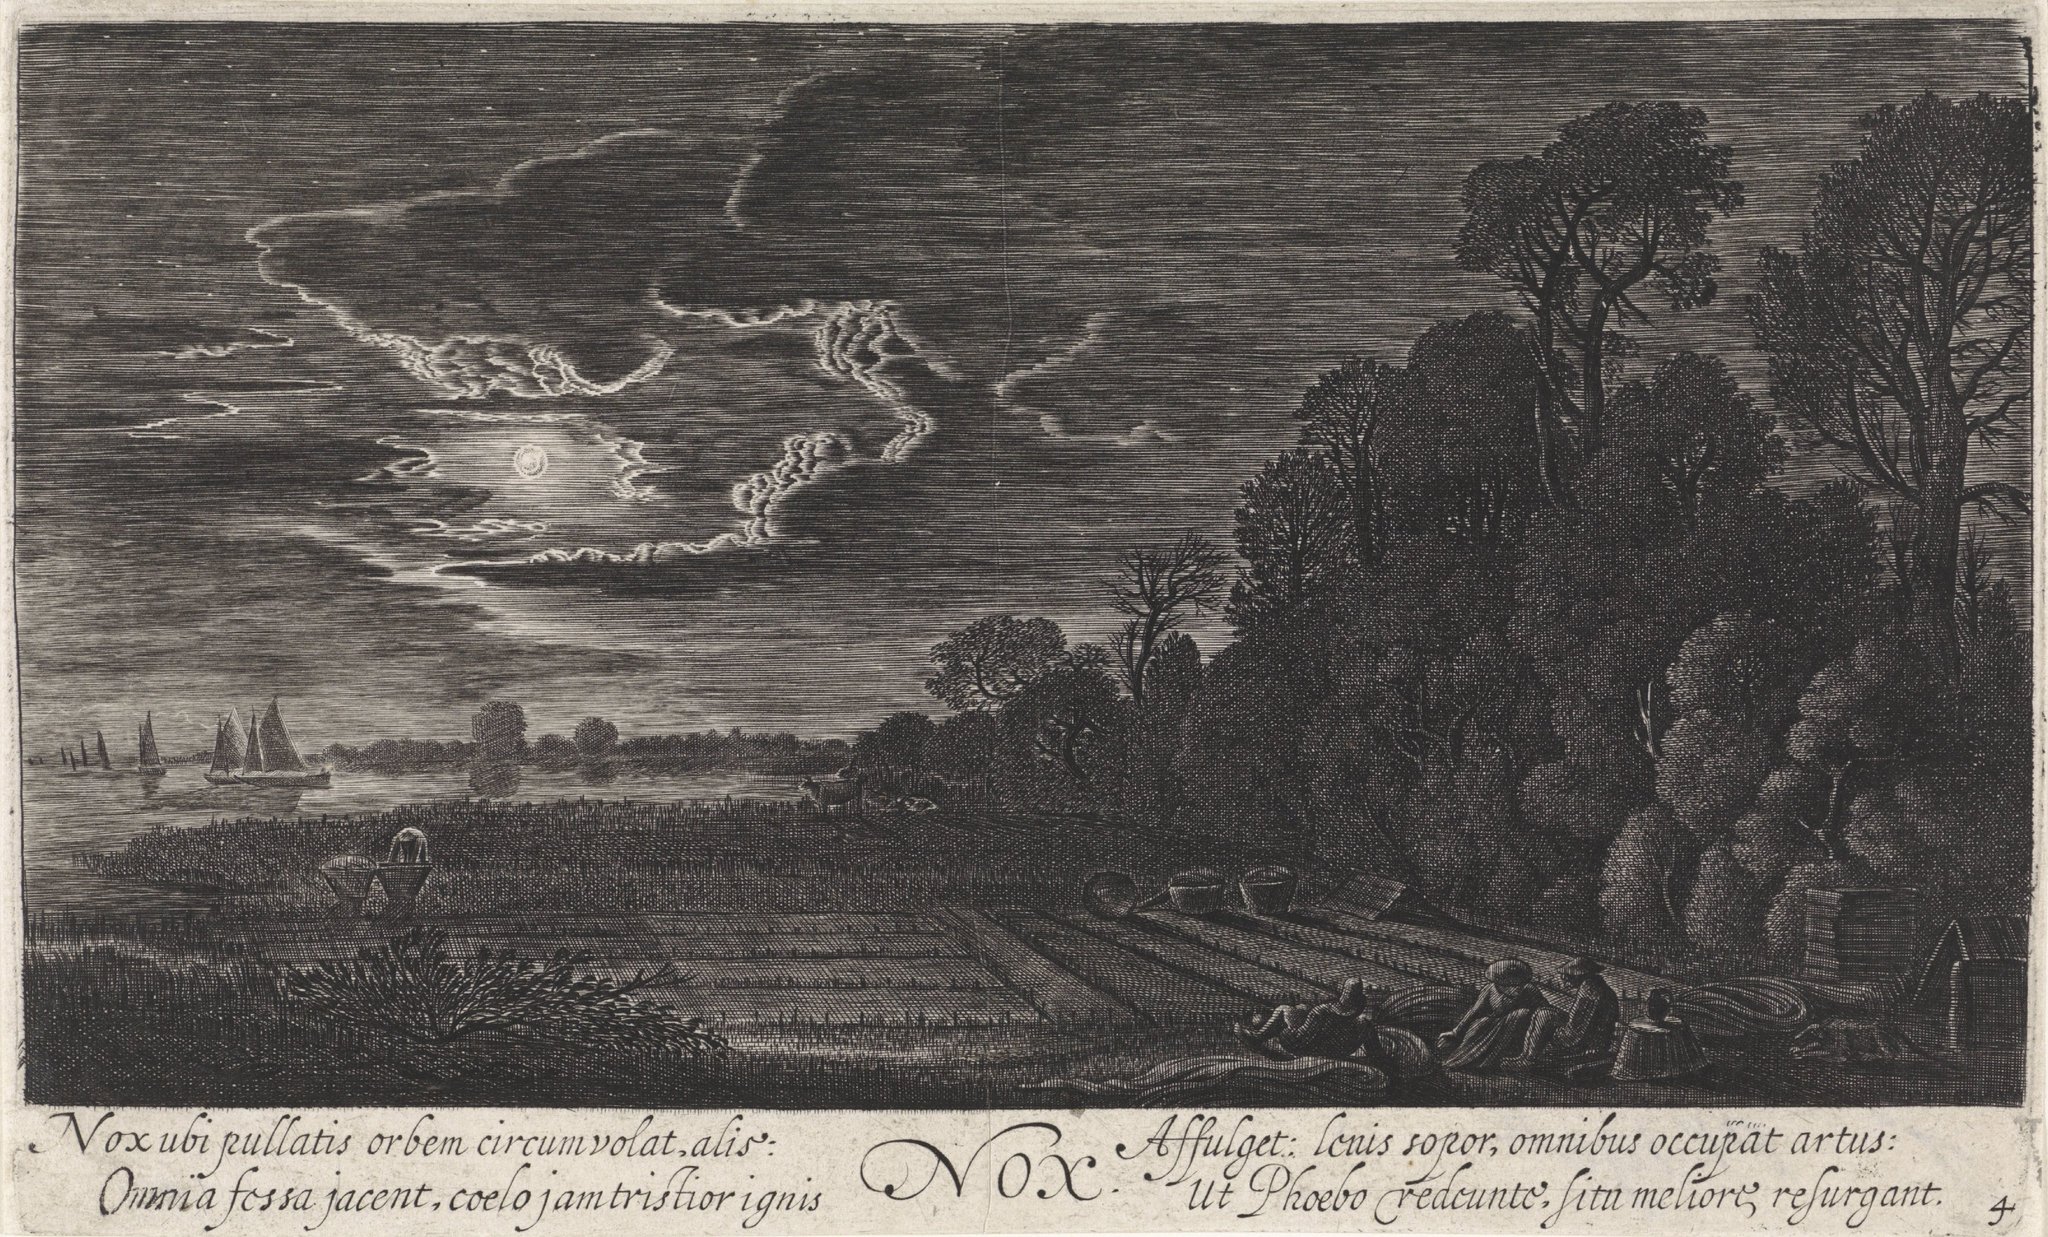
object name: print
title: Nox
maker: jan van de velde (ii)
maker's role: draughtsman, painter, print maker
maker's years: 1593-1641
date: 1603-1641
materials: paper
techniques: engraving, etching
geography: northern netherlands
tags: full moon, night ~ landscape (sometimes titled 'nox'), finch trap, finchery, resting - bb - out of doors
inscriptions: collector's mark: Lugt 964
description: Nachtlandschap met zeilscheepjes op het water en rechts op de voorgrond een groepje rustende vogelvangers, aan de hemel een maan, voorstellende de nacht. Prent uit een serie van vier.